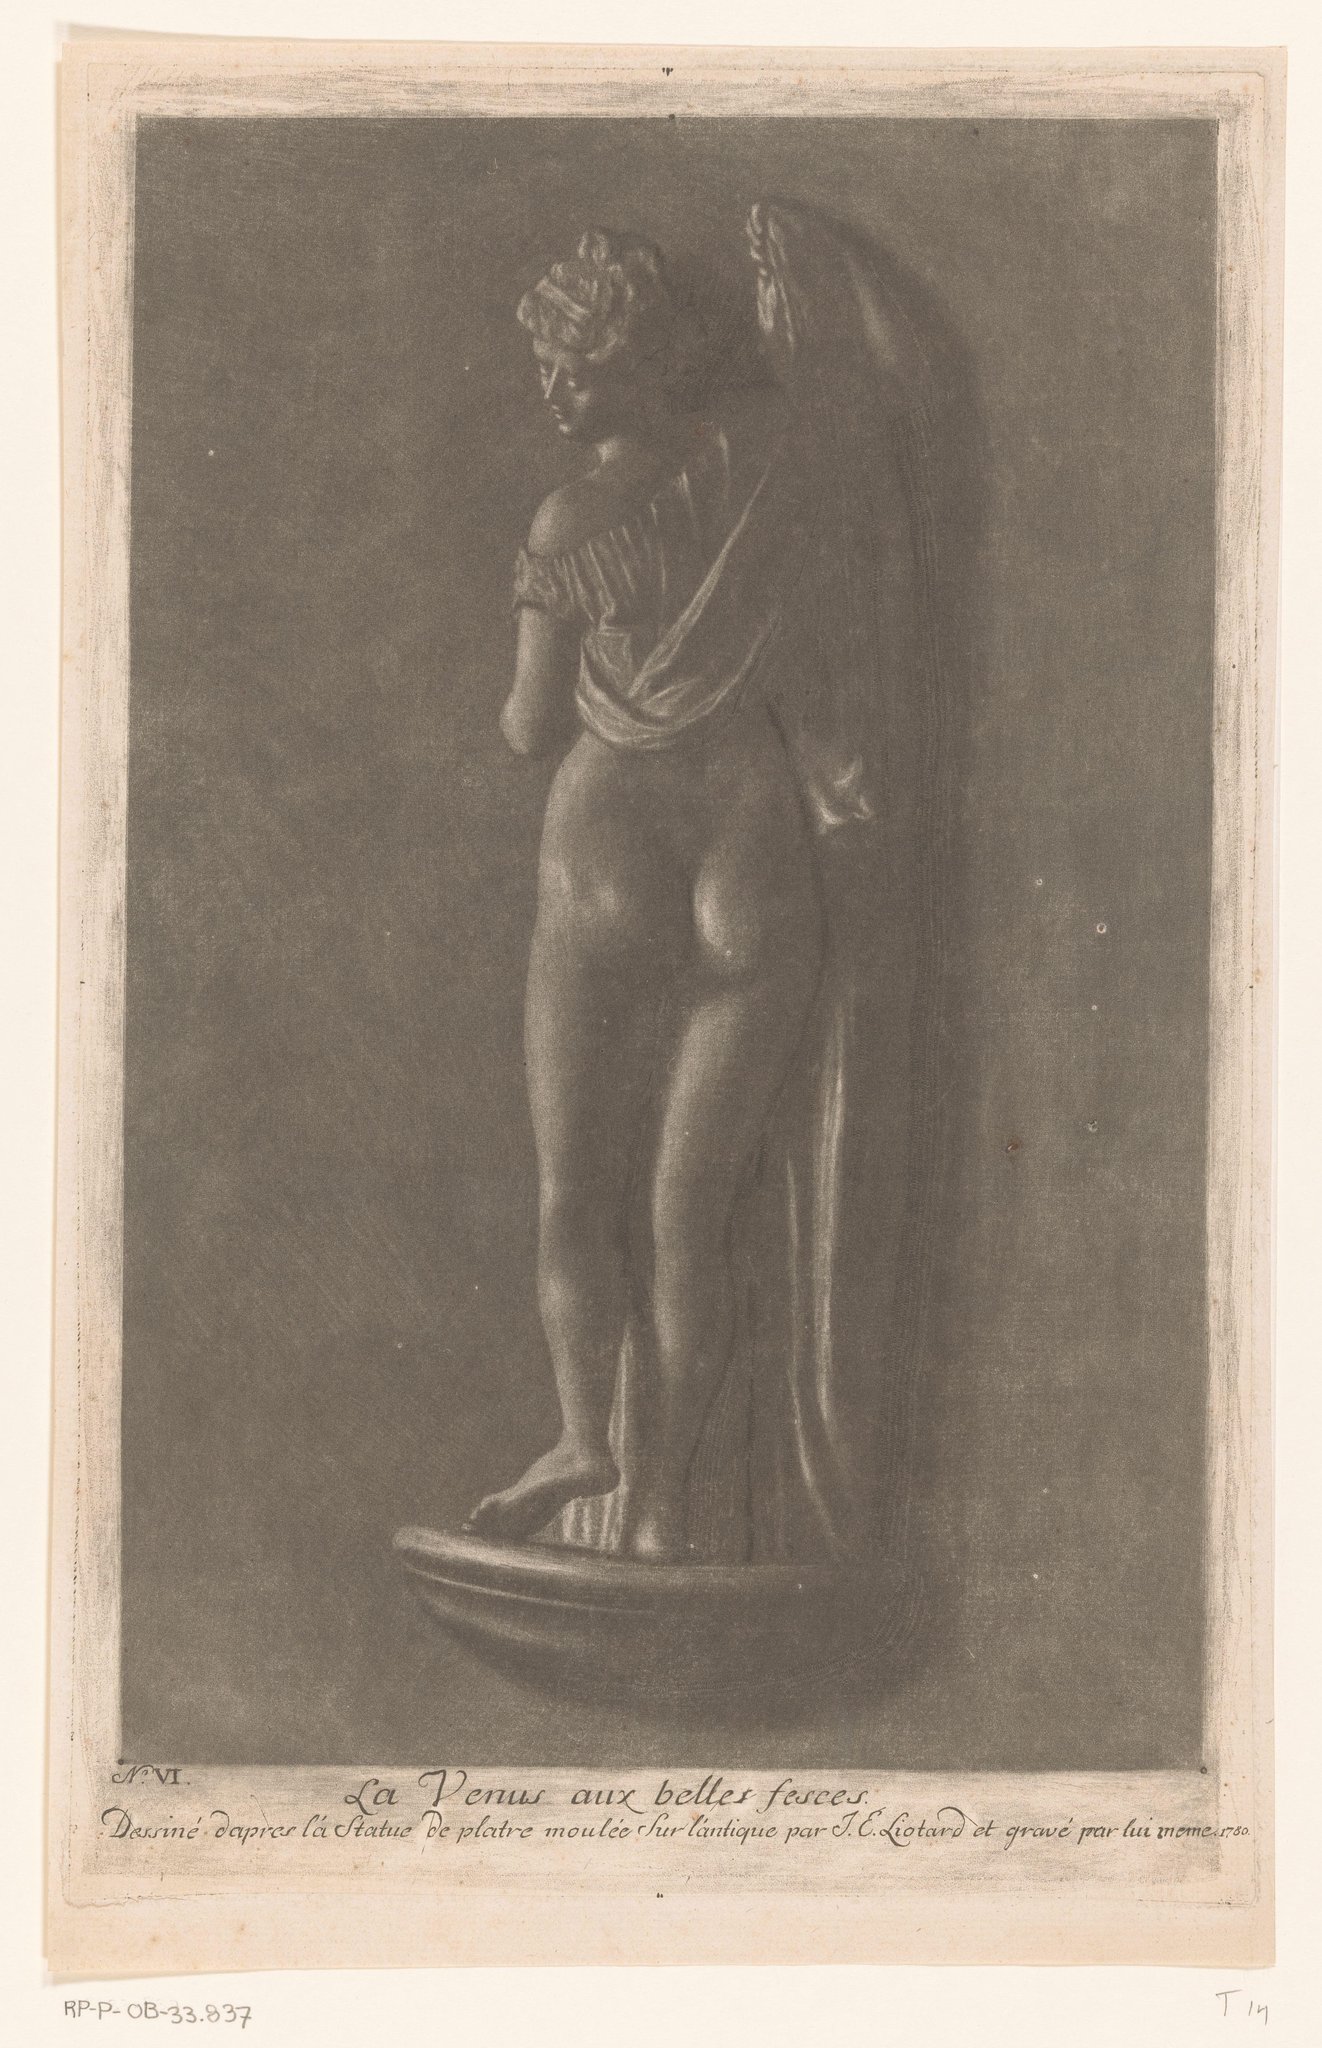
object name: print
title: La Venus aux belles fesces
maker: jean-etienne liotard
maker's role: painter, print maker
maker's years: 1702-1789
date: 1780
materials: paper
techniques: etching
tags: (story of) venus (aphrodite)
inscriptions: collector's mark: Lugt 2228